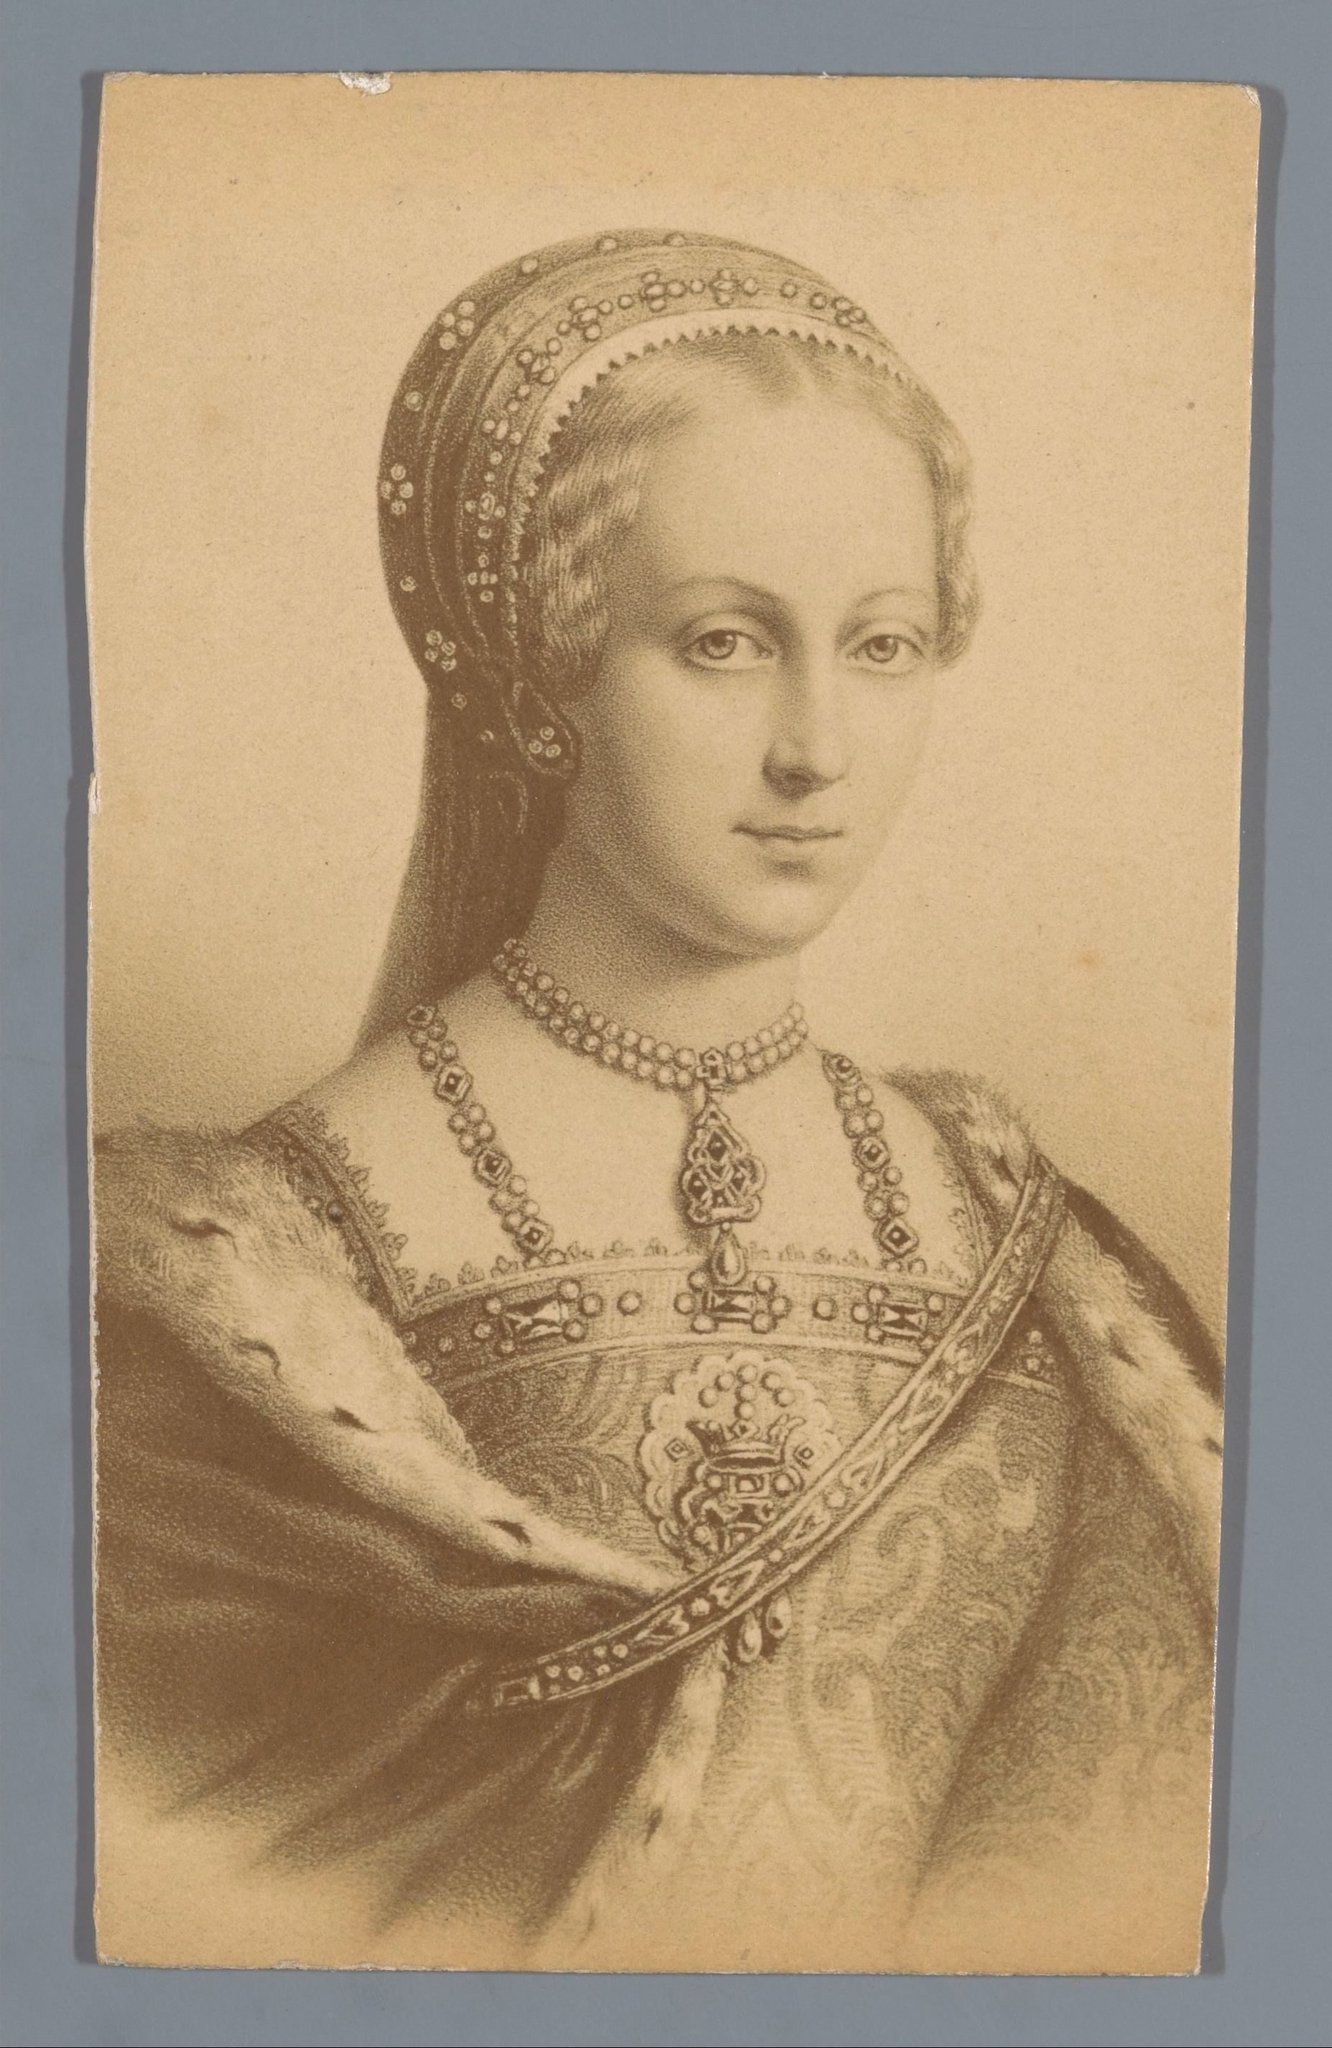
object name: reproduction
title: Fotoreproductie van een portret van een onbekende vrouw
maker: Anonymous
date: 1860-1900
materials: cardboard, photographic support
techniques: albumen print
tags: adult woman, anonymous historical person portrayed